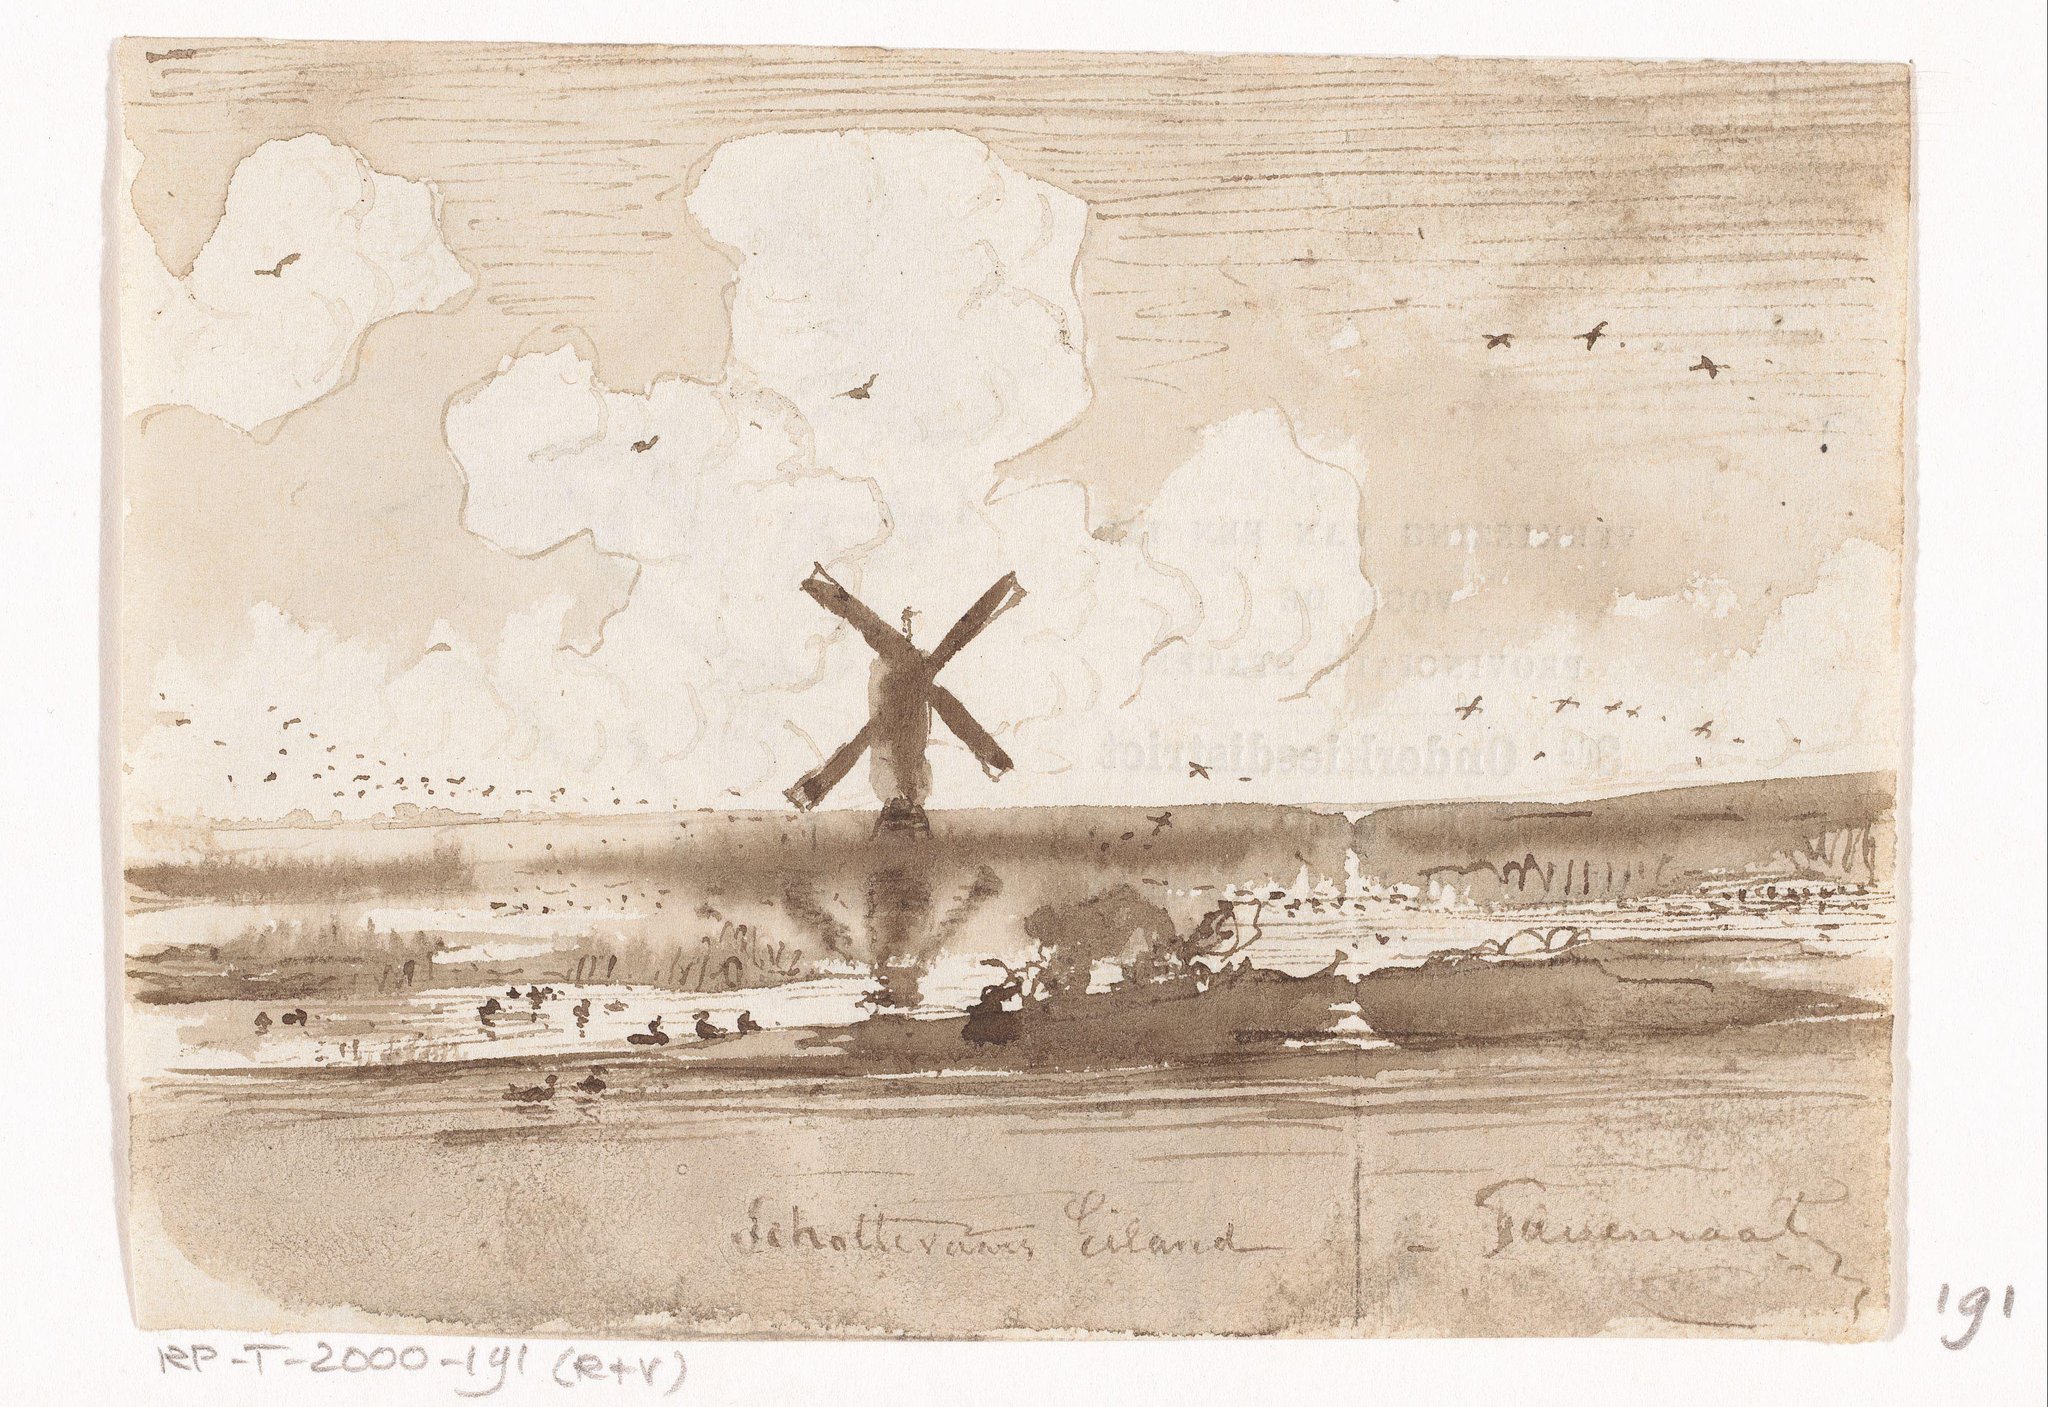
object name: drawing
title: Rivierlandschap met molen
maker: johannes tavenraat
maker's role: draughtsman, painter, print maker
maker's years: 1809-1881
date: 1840-1880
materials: ink, paper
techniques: brush, pen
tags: windmill in landscape, river (+ landscape with figures, staffage)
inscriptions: annotation: ‘Schottevaars Eiland / Tavenraat’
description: Rivierlandschap met molen. Getekend op de achterzijde van een deel van een stembiljet voor de verkiezing van een een lid van de Provinciale Staten uit Rotterdam.